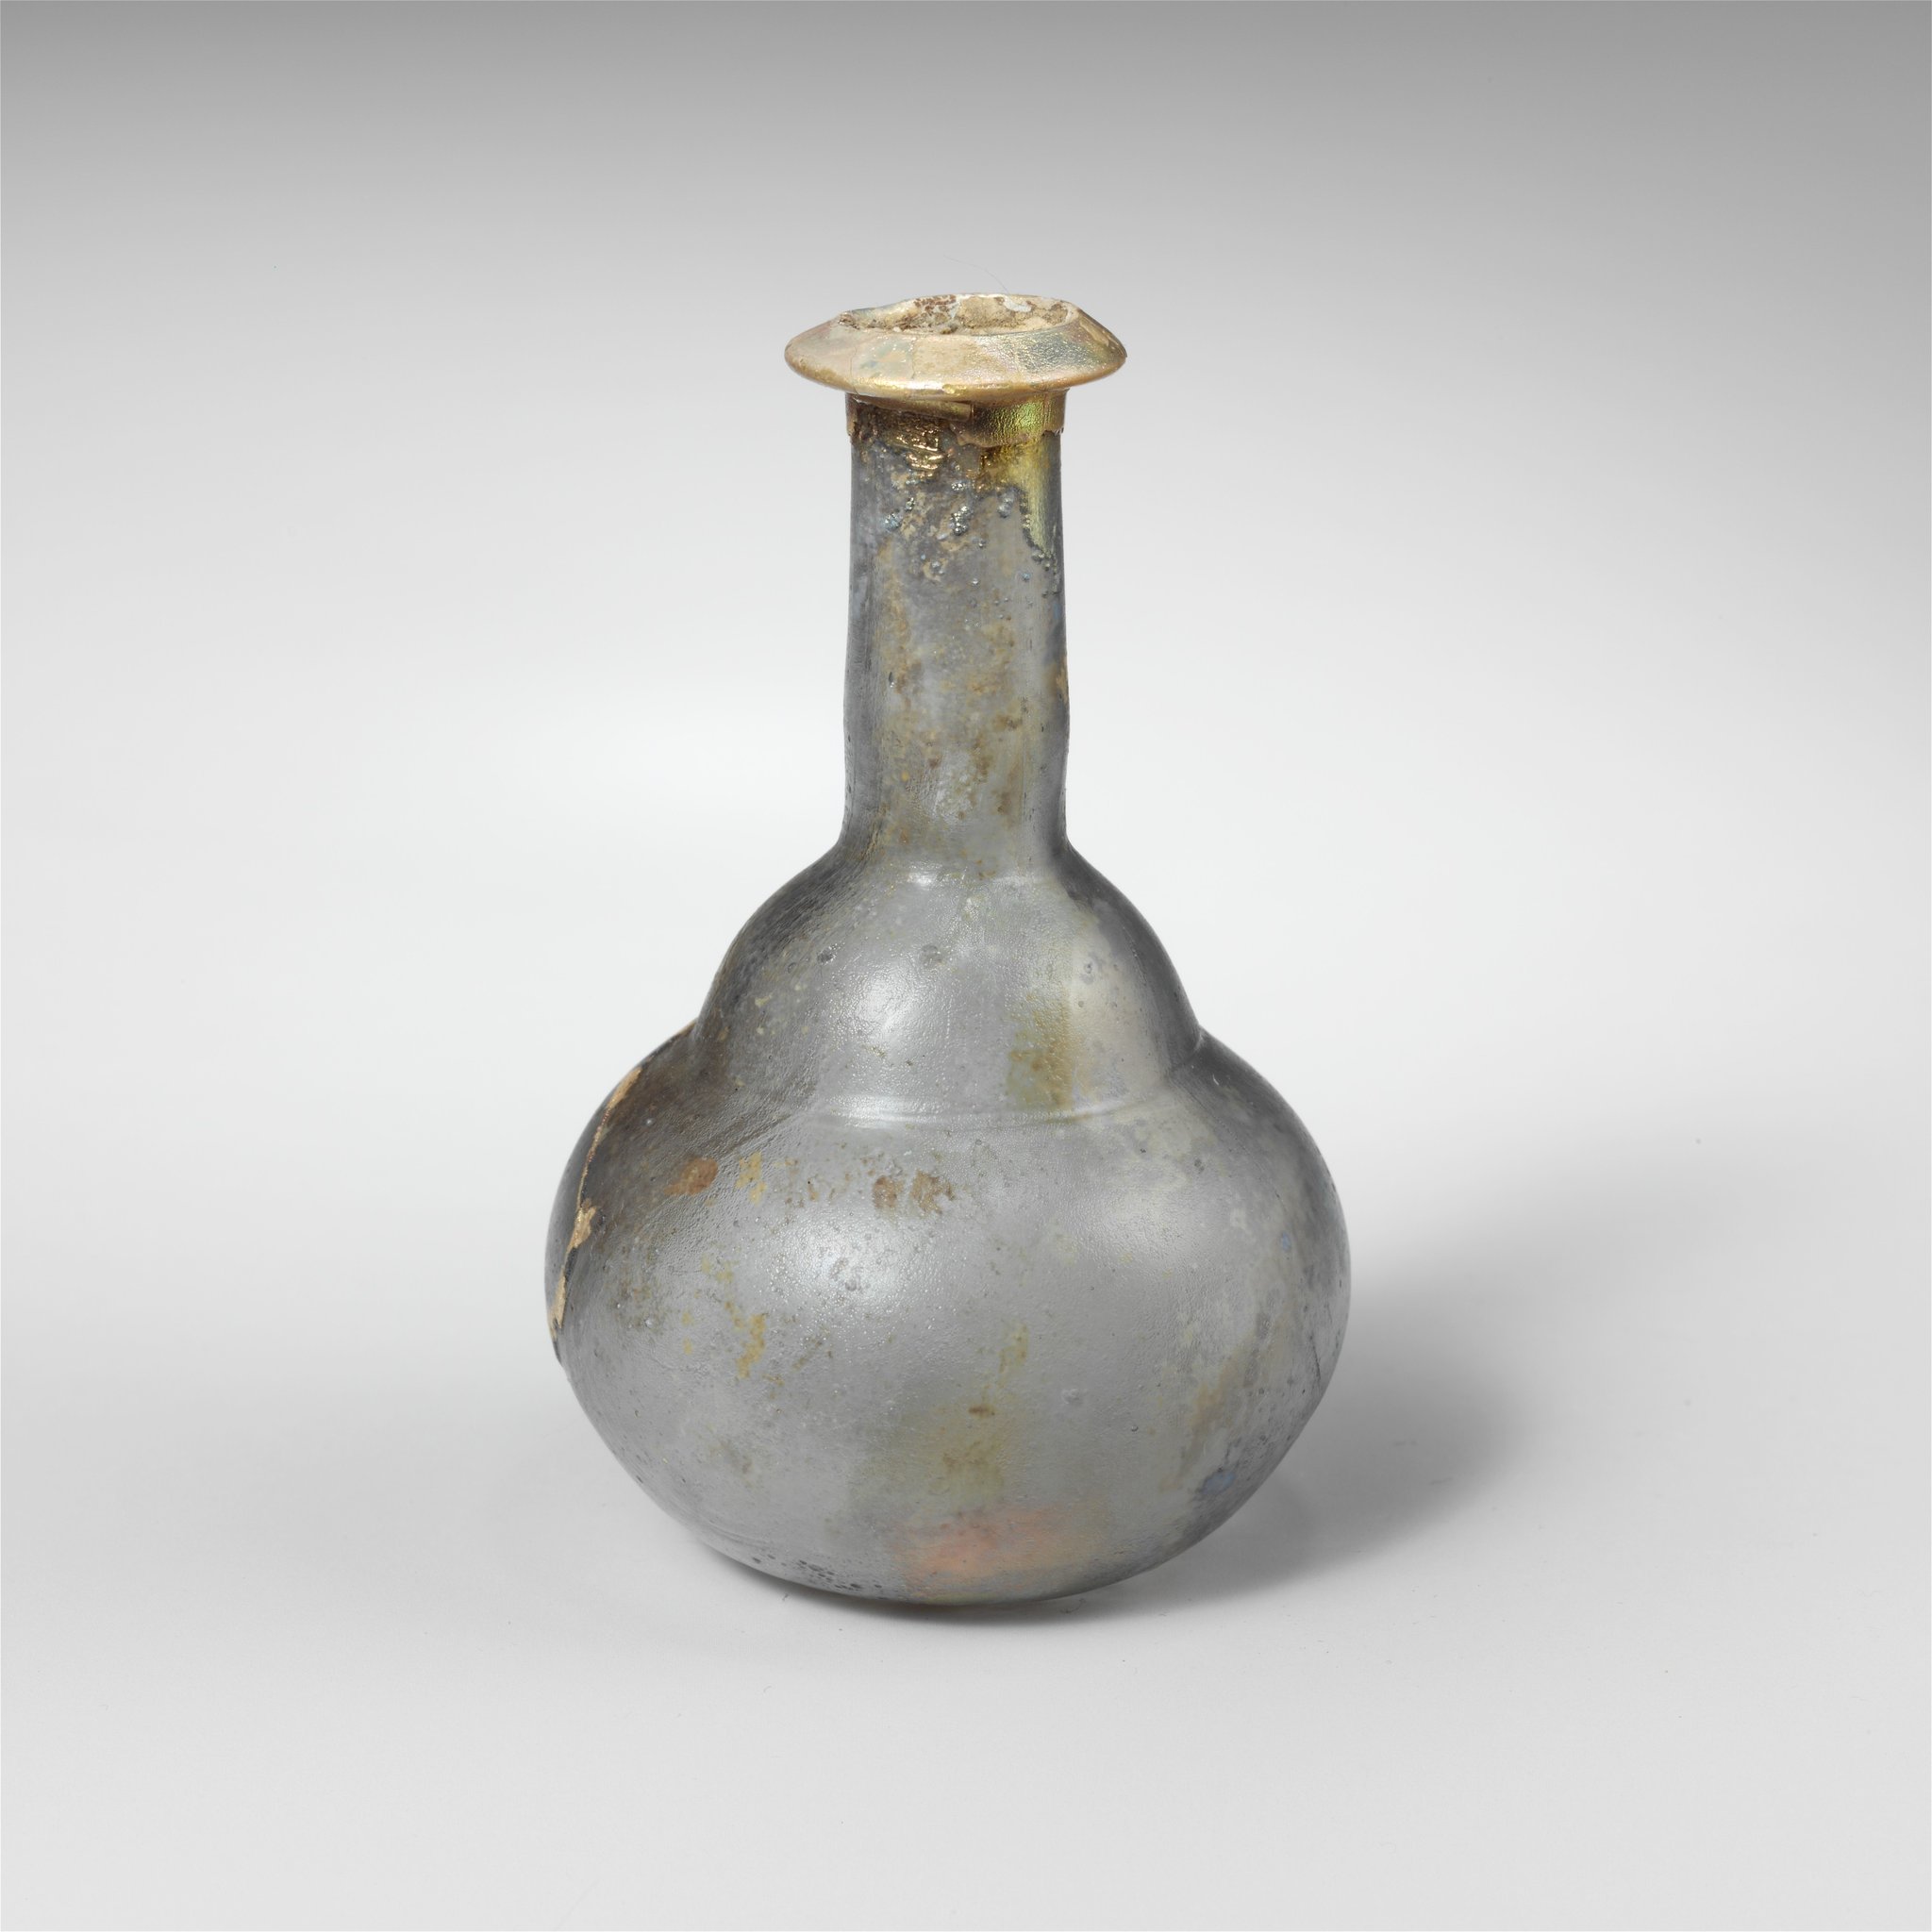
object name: perfume bottle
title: Glass perfume bottle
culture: roman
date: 1-100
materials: glass